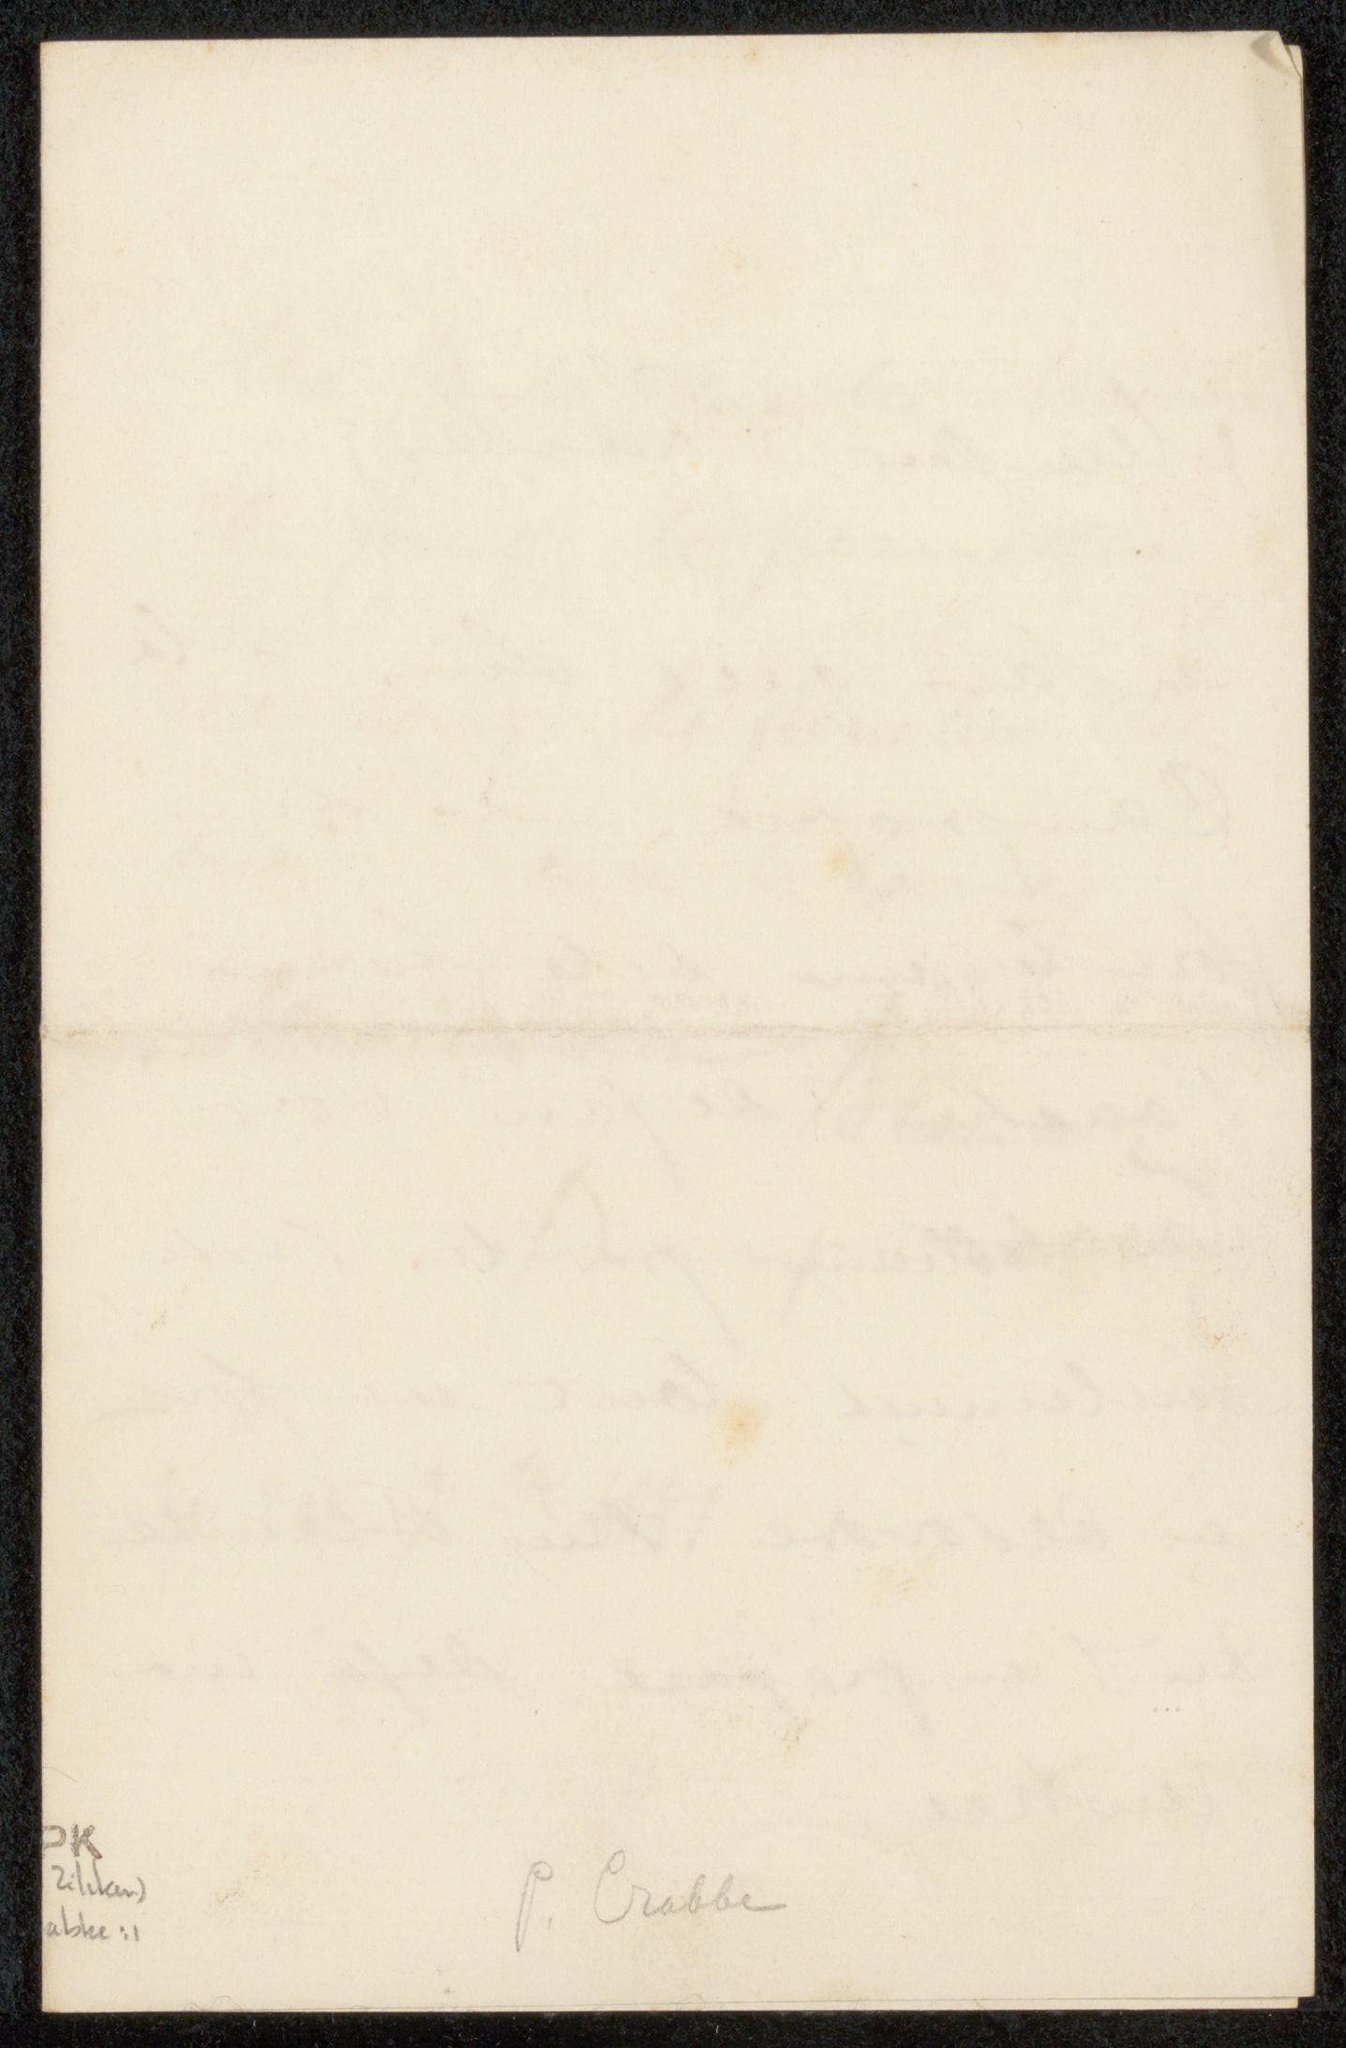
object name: letter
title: Brief aan Philip Zilcken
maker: prosper crabbe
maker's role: kunstverzamelaar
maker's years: 1827-1889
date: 1881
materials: ink, paper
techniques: pen, writing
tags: the hague, painter, draughtsman, philip zilcken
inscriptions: collector's mark: ‘RPK’, watermark